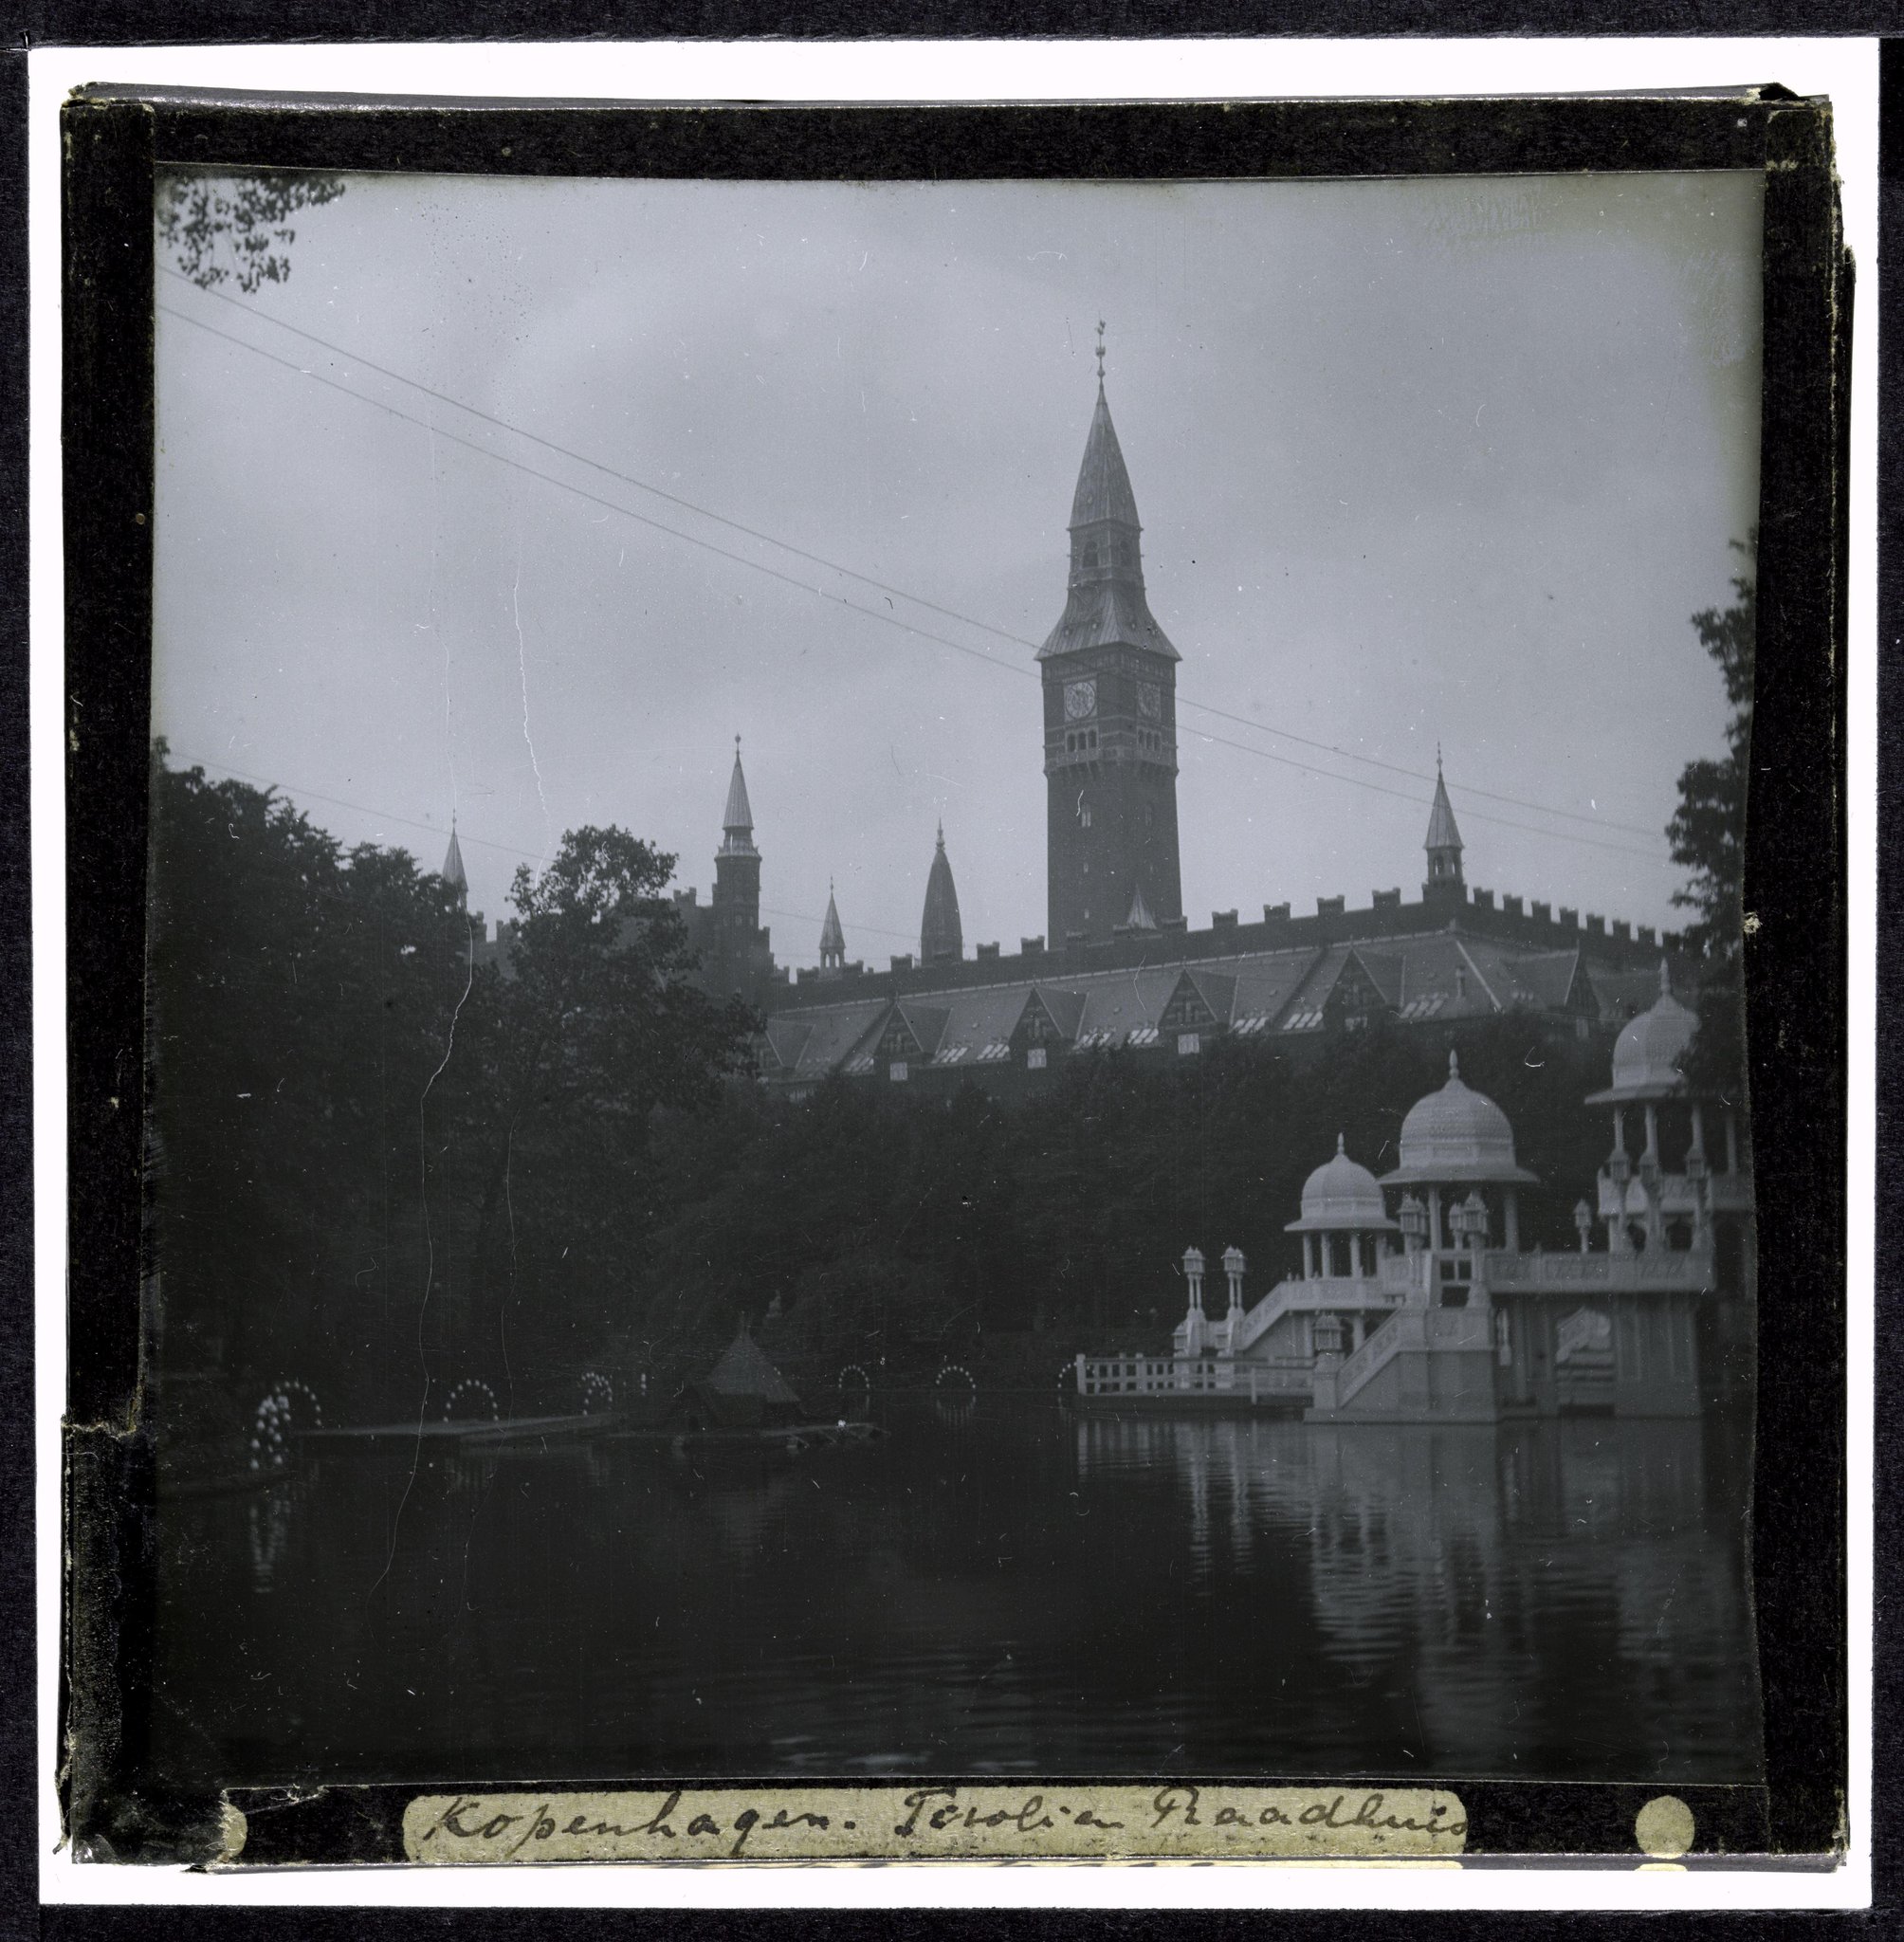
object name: photograph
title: Kopenhagen. [...] Raadhuis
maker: Anonymous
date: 1907-1935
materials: glass, ink, paper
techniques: slide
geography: copenhagen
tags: townhall, copenhagen (city)